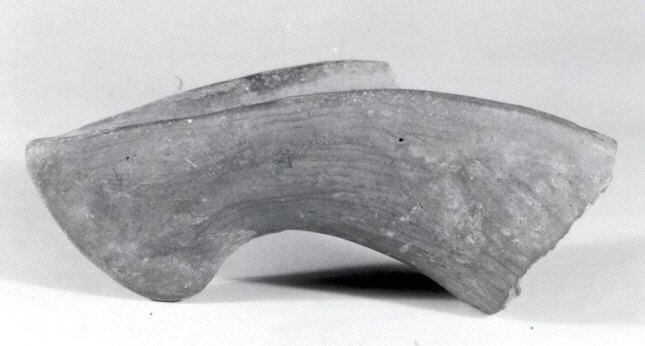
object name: spout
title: Curved spout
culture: assyrian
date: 1800-1701 BCE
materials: ceramic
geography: anatolia